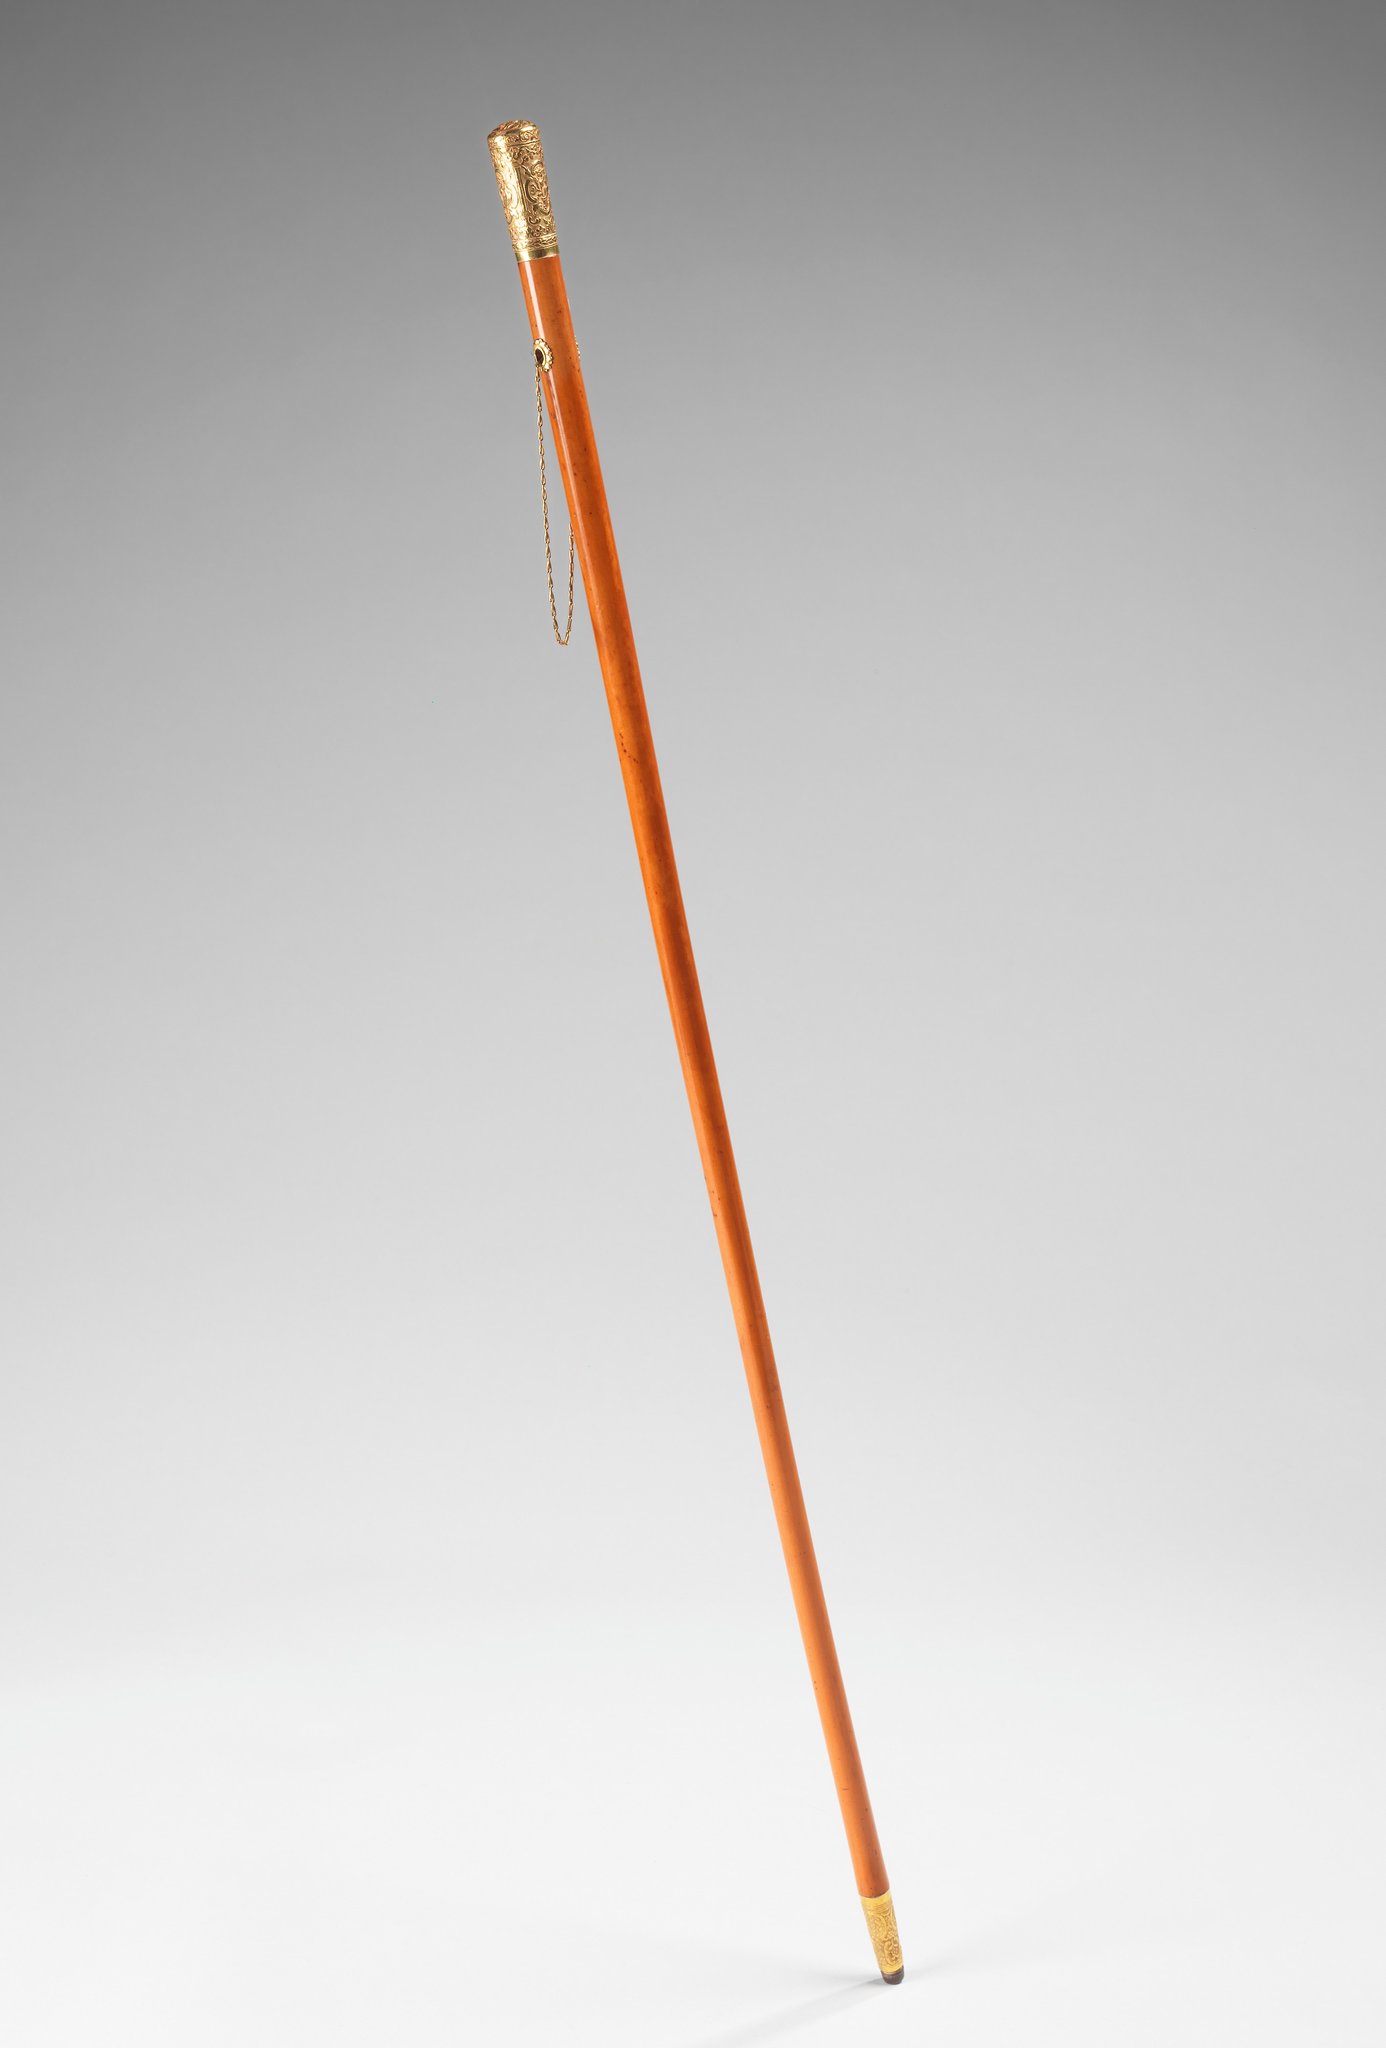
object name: cane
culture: french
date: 1895-1905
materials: metal, wood